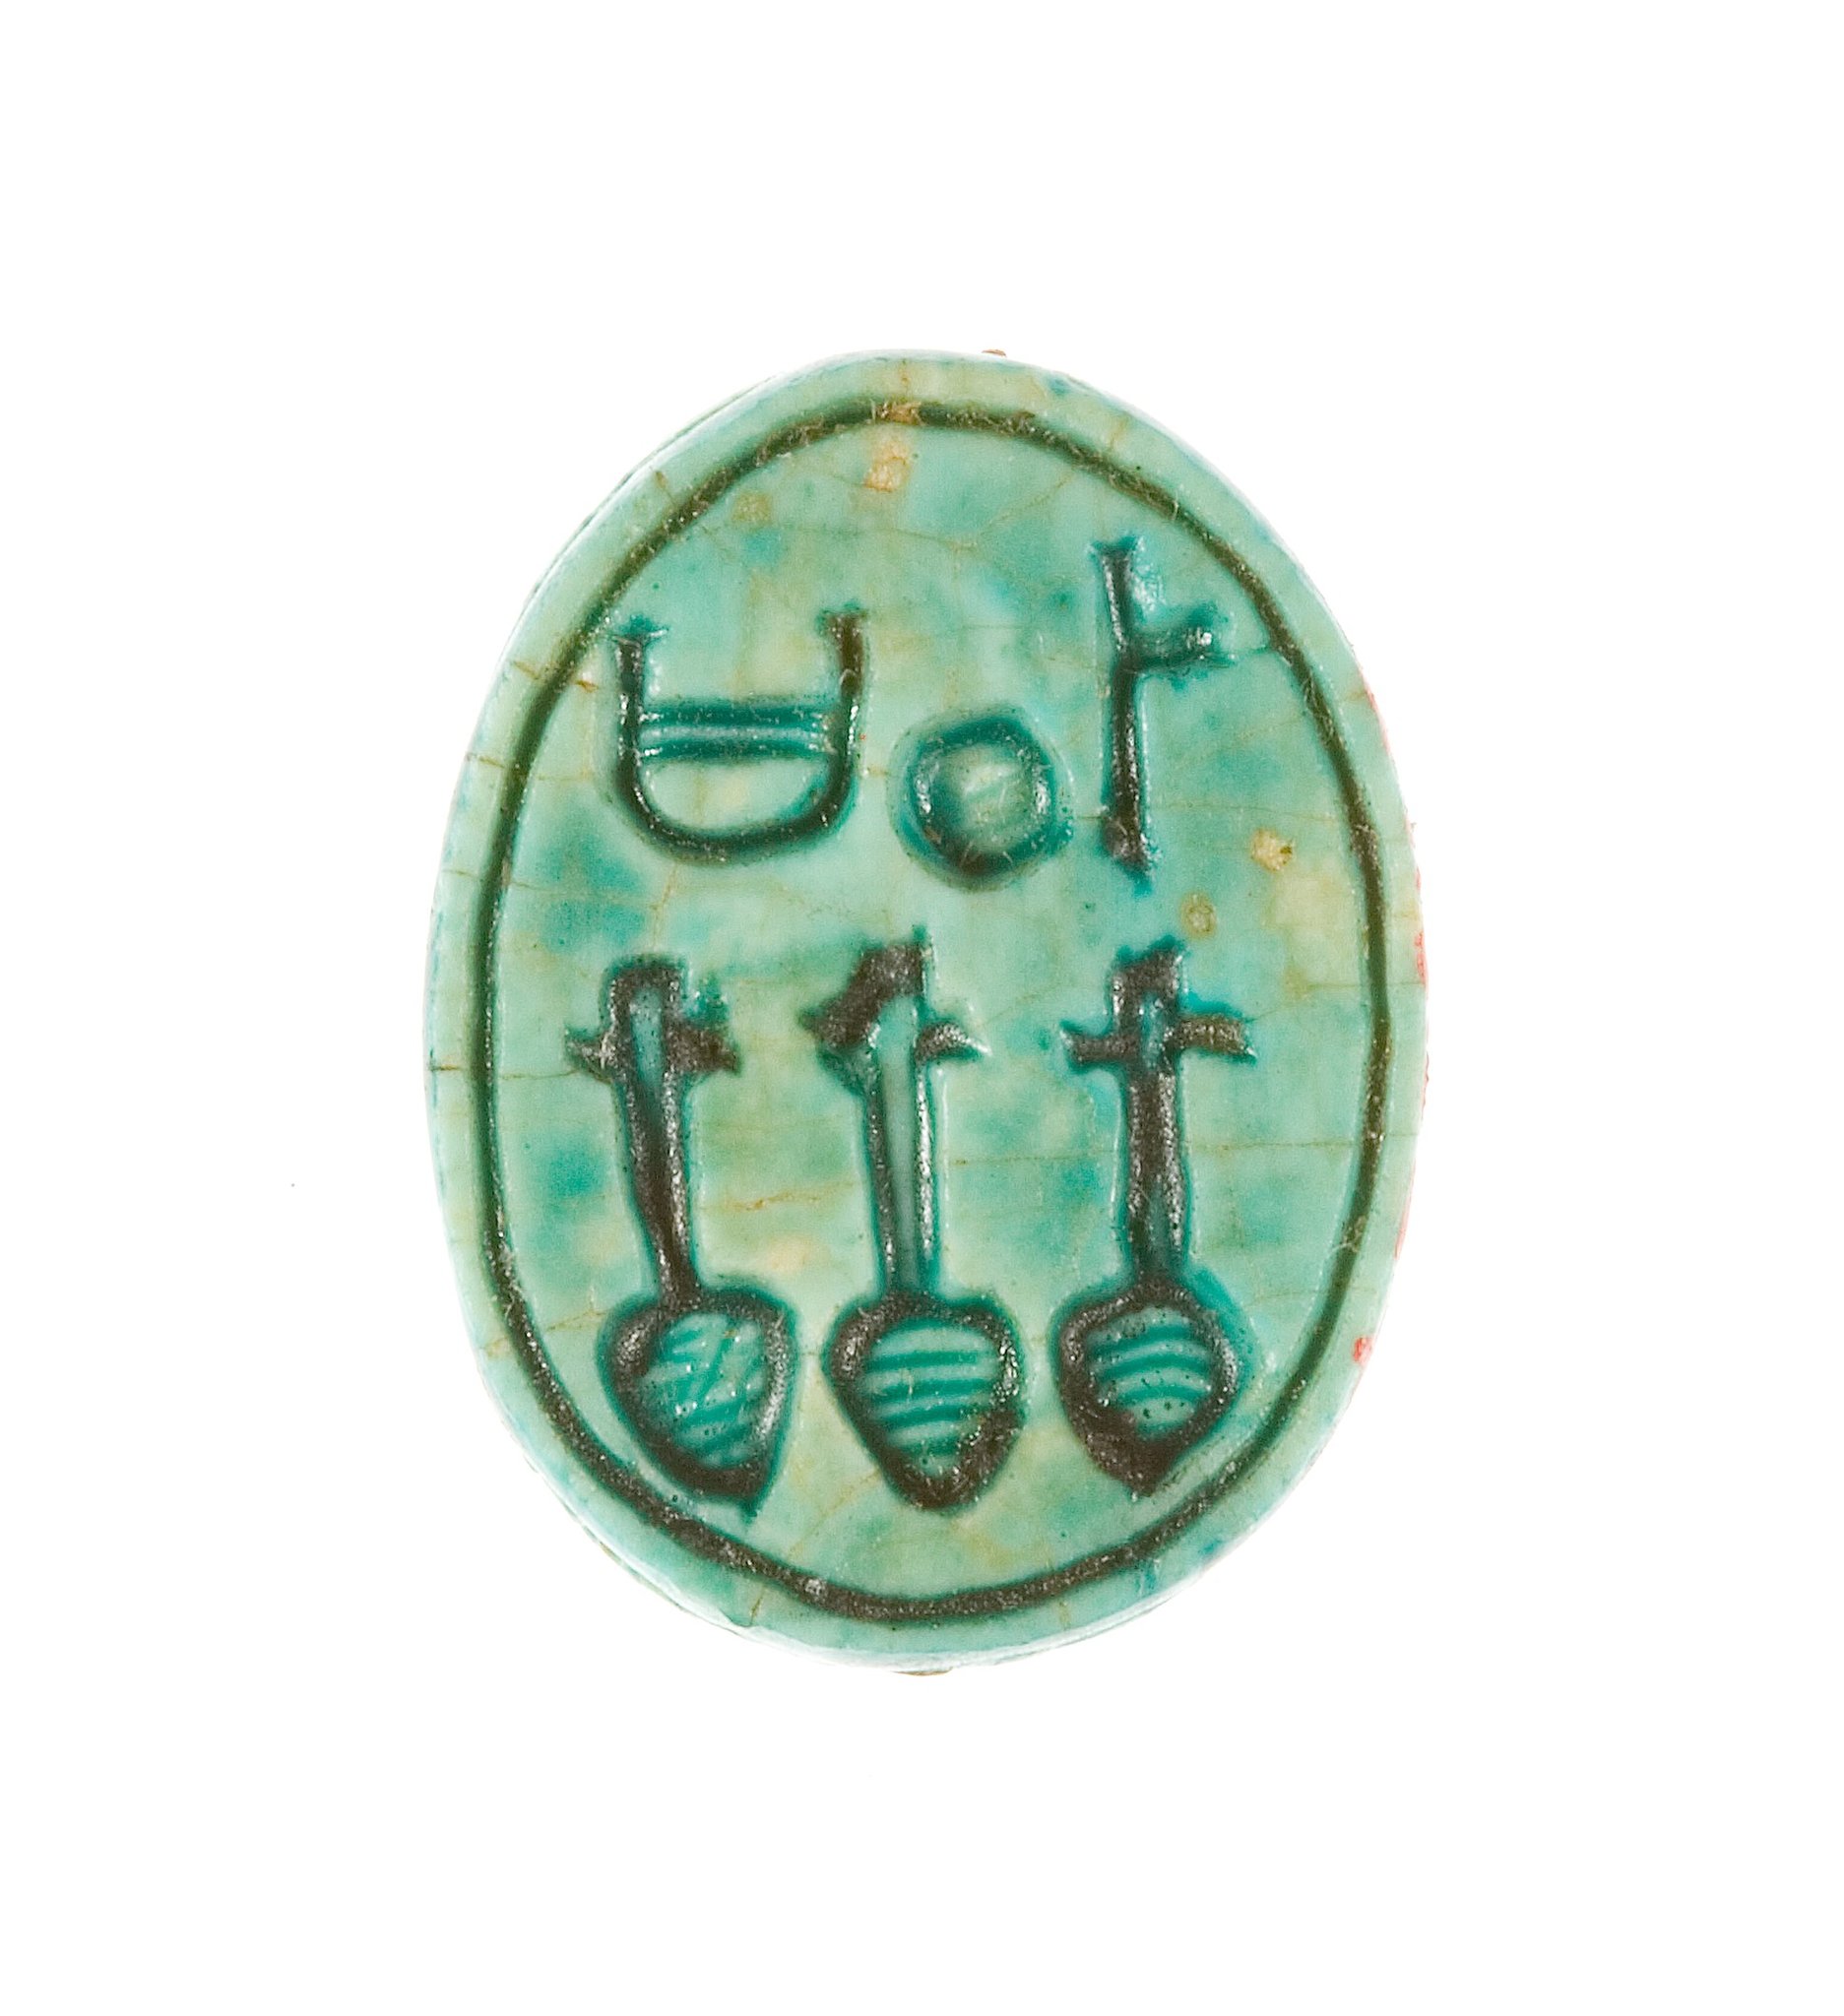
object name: scarab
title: Scarabs Inscribed for the God's Wife Neferure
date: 1479-1458 BCE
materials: stone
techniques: glazing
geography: egypt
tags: hieroglyphs,scarabs